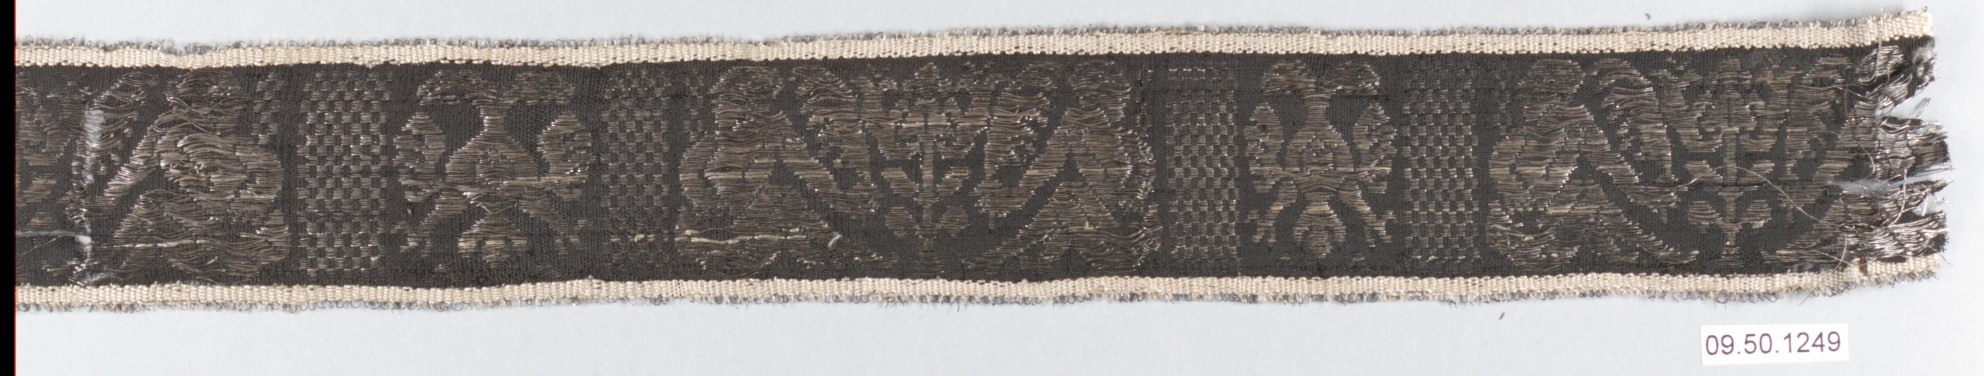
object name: galloon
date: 1701-1800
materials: metal thread, silk